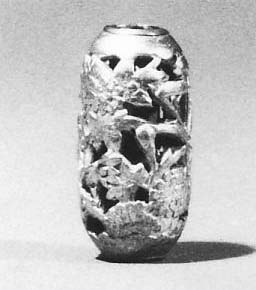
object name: ojime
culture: japanese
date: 1701-1800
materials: gold